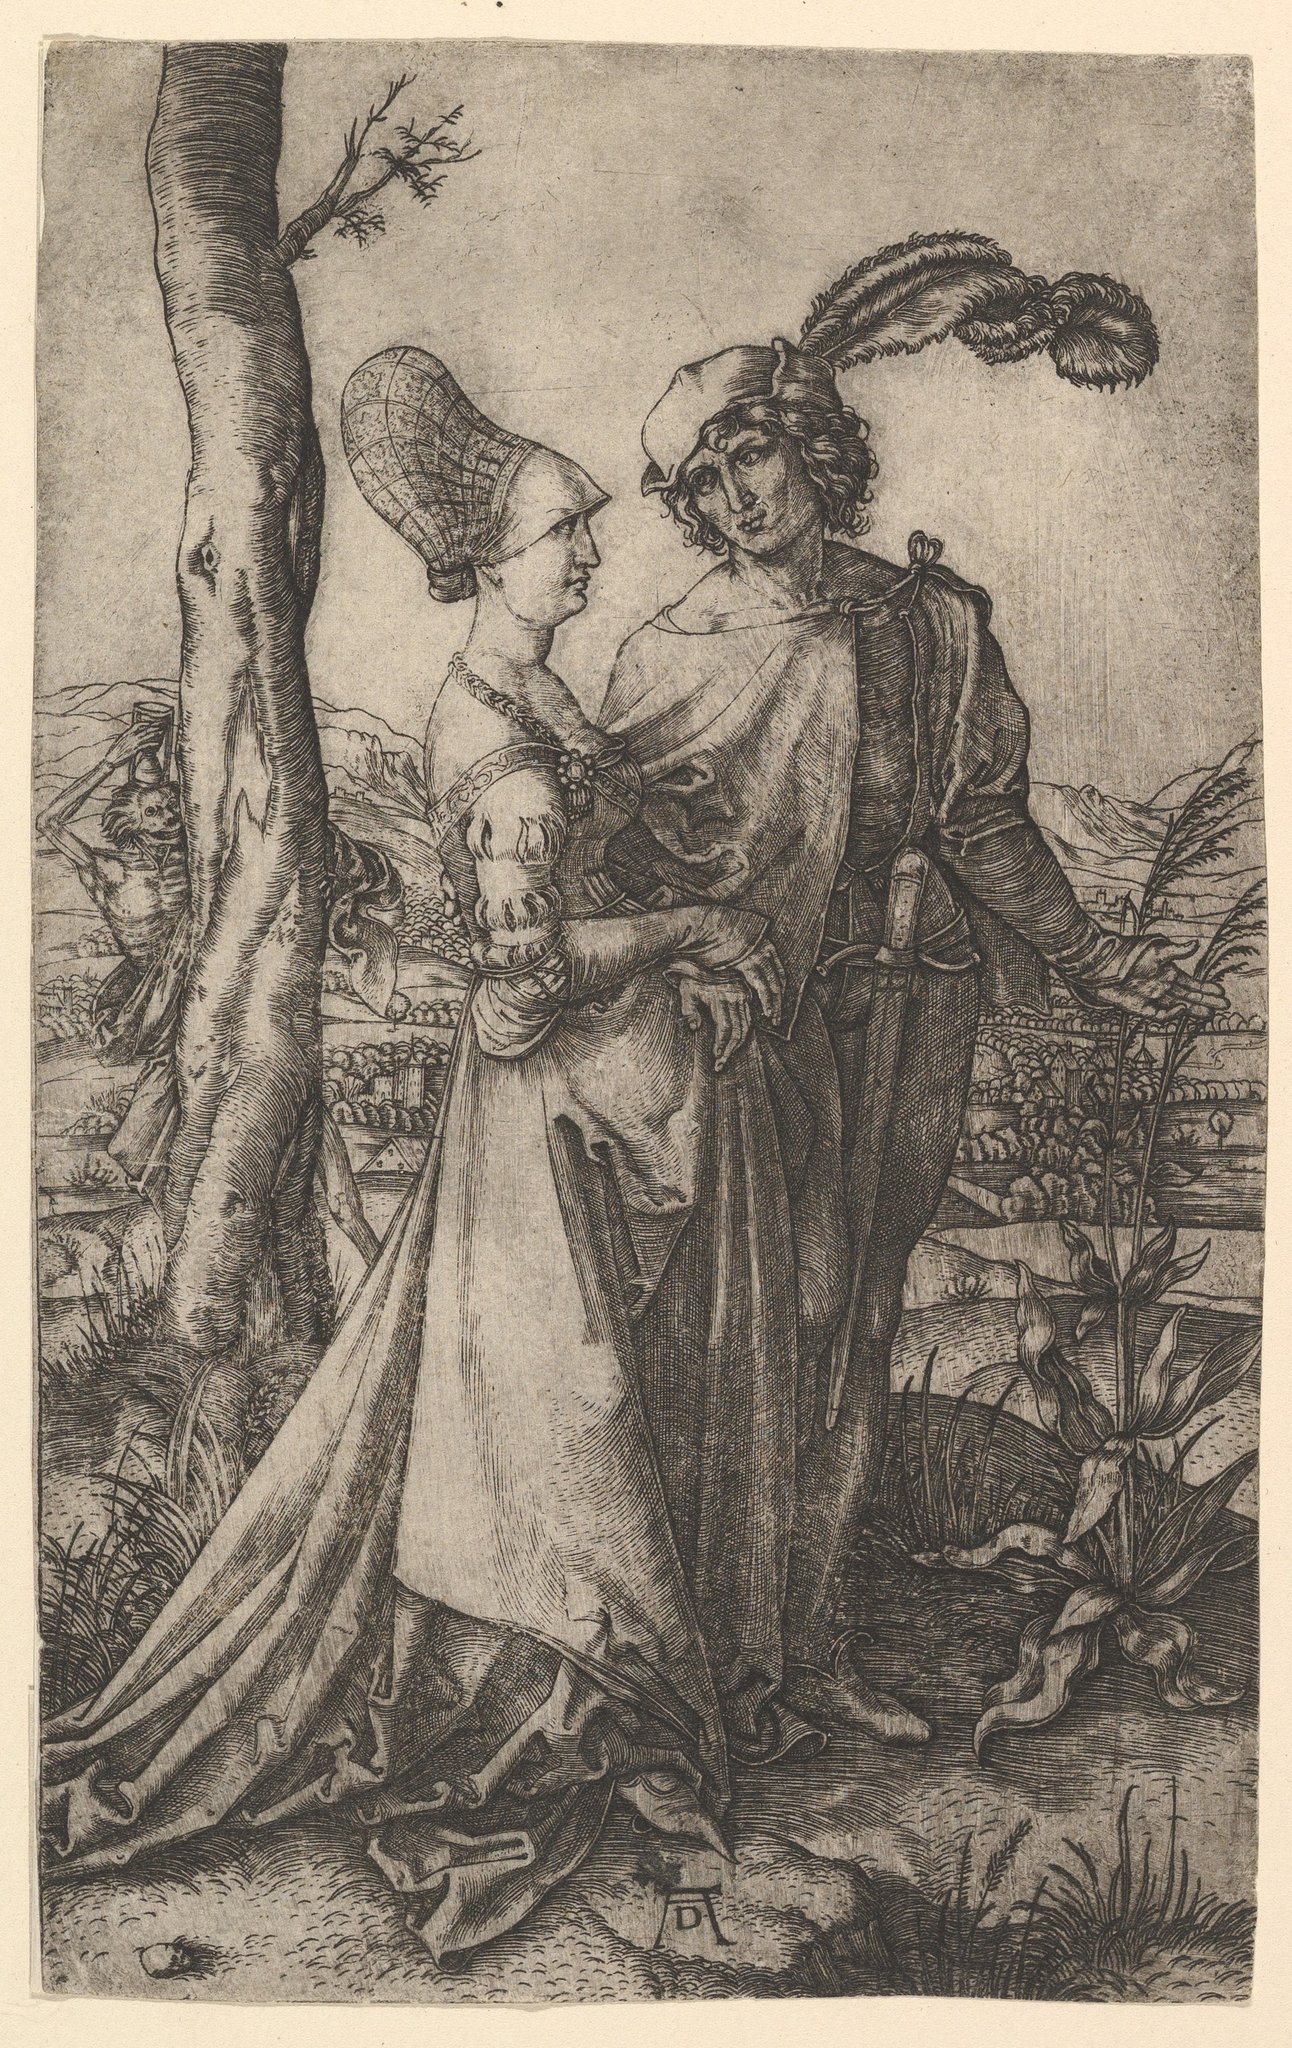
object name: print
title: Lord and lady walking with figure of death hiding behind a tree, holding an hourglass, The Promenade after Dürer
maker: marcantonio raimondi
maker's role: artist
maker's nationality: italian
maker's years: 1475-1534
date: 1500-1534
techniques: engraving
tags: skeletons,men,women,trees,hourglass